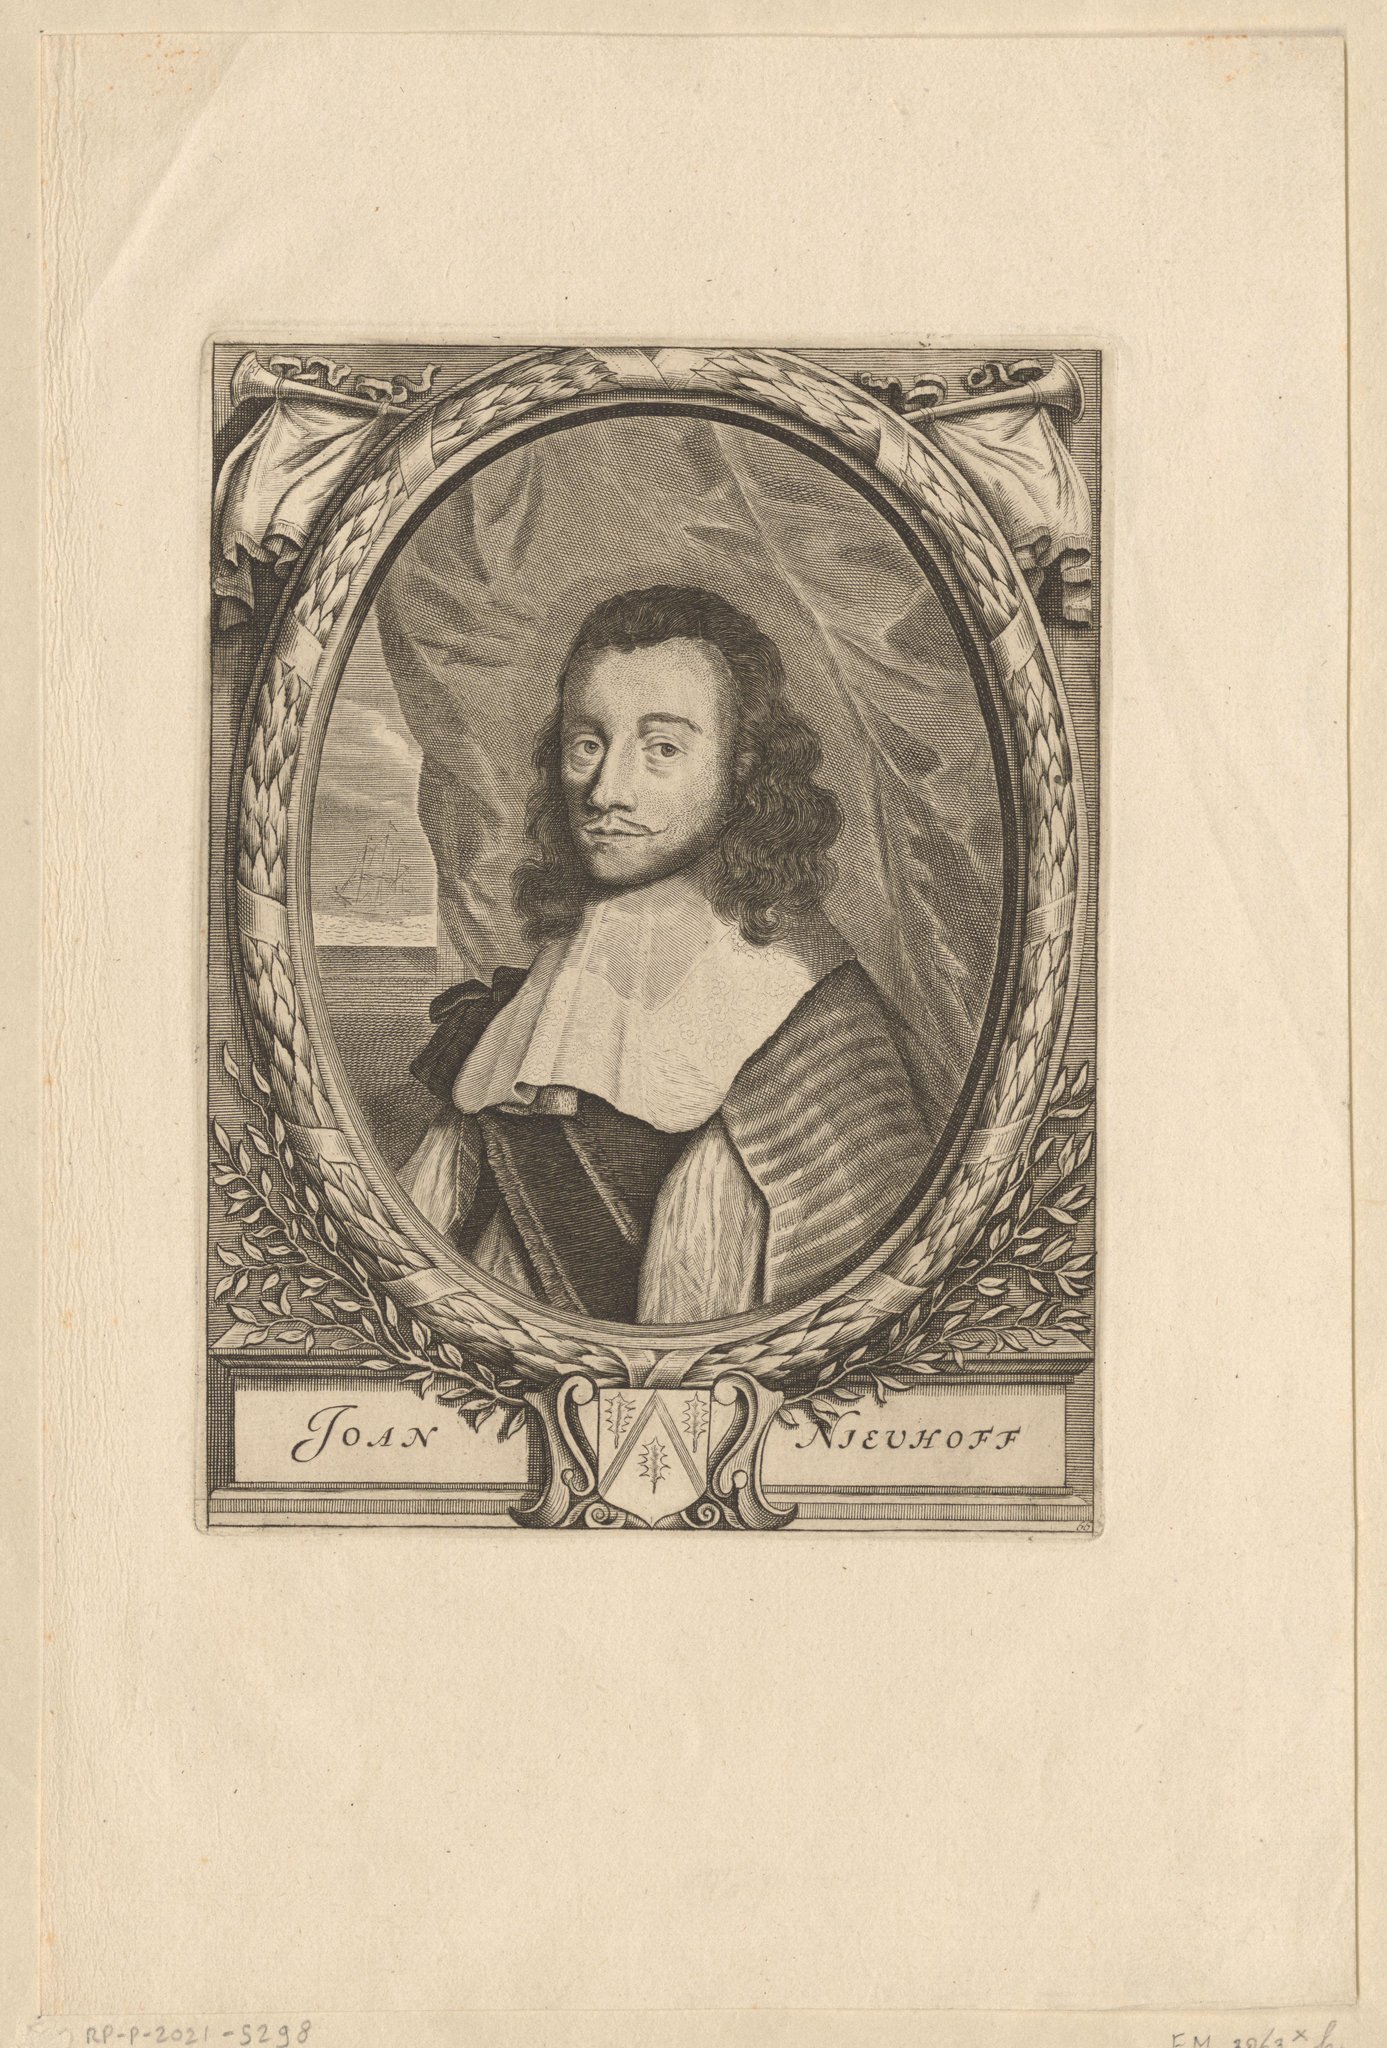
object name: print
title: Portret van Joan Nieuhof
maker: Anonymous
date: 1668-1799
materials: paper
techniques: engraving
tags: joan nieuhof, historical persons, ships (in general), explorer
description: Kopie naar prent gebruikt in: Nieuhof, Joan. Legatio Batavica ad magnum Tartariae Chamum Sungteium (...). Amsterdam: Jacob Meurs, 1668. Muller vermeldt deze prent als zijnde een latere staat en zeer late afdruk van prent gebruikt in 1668. Vermoedelijk gaat het om een kopie in plaats van een latere staat.